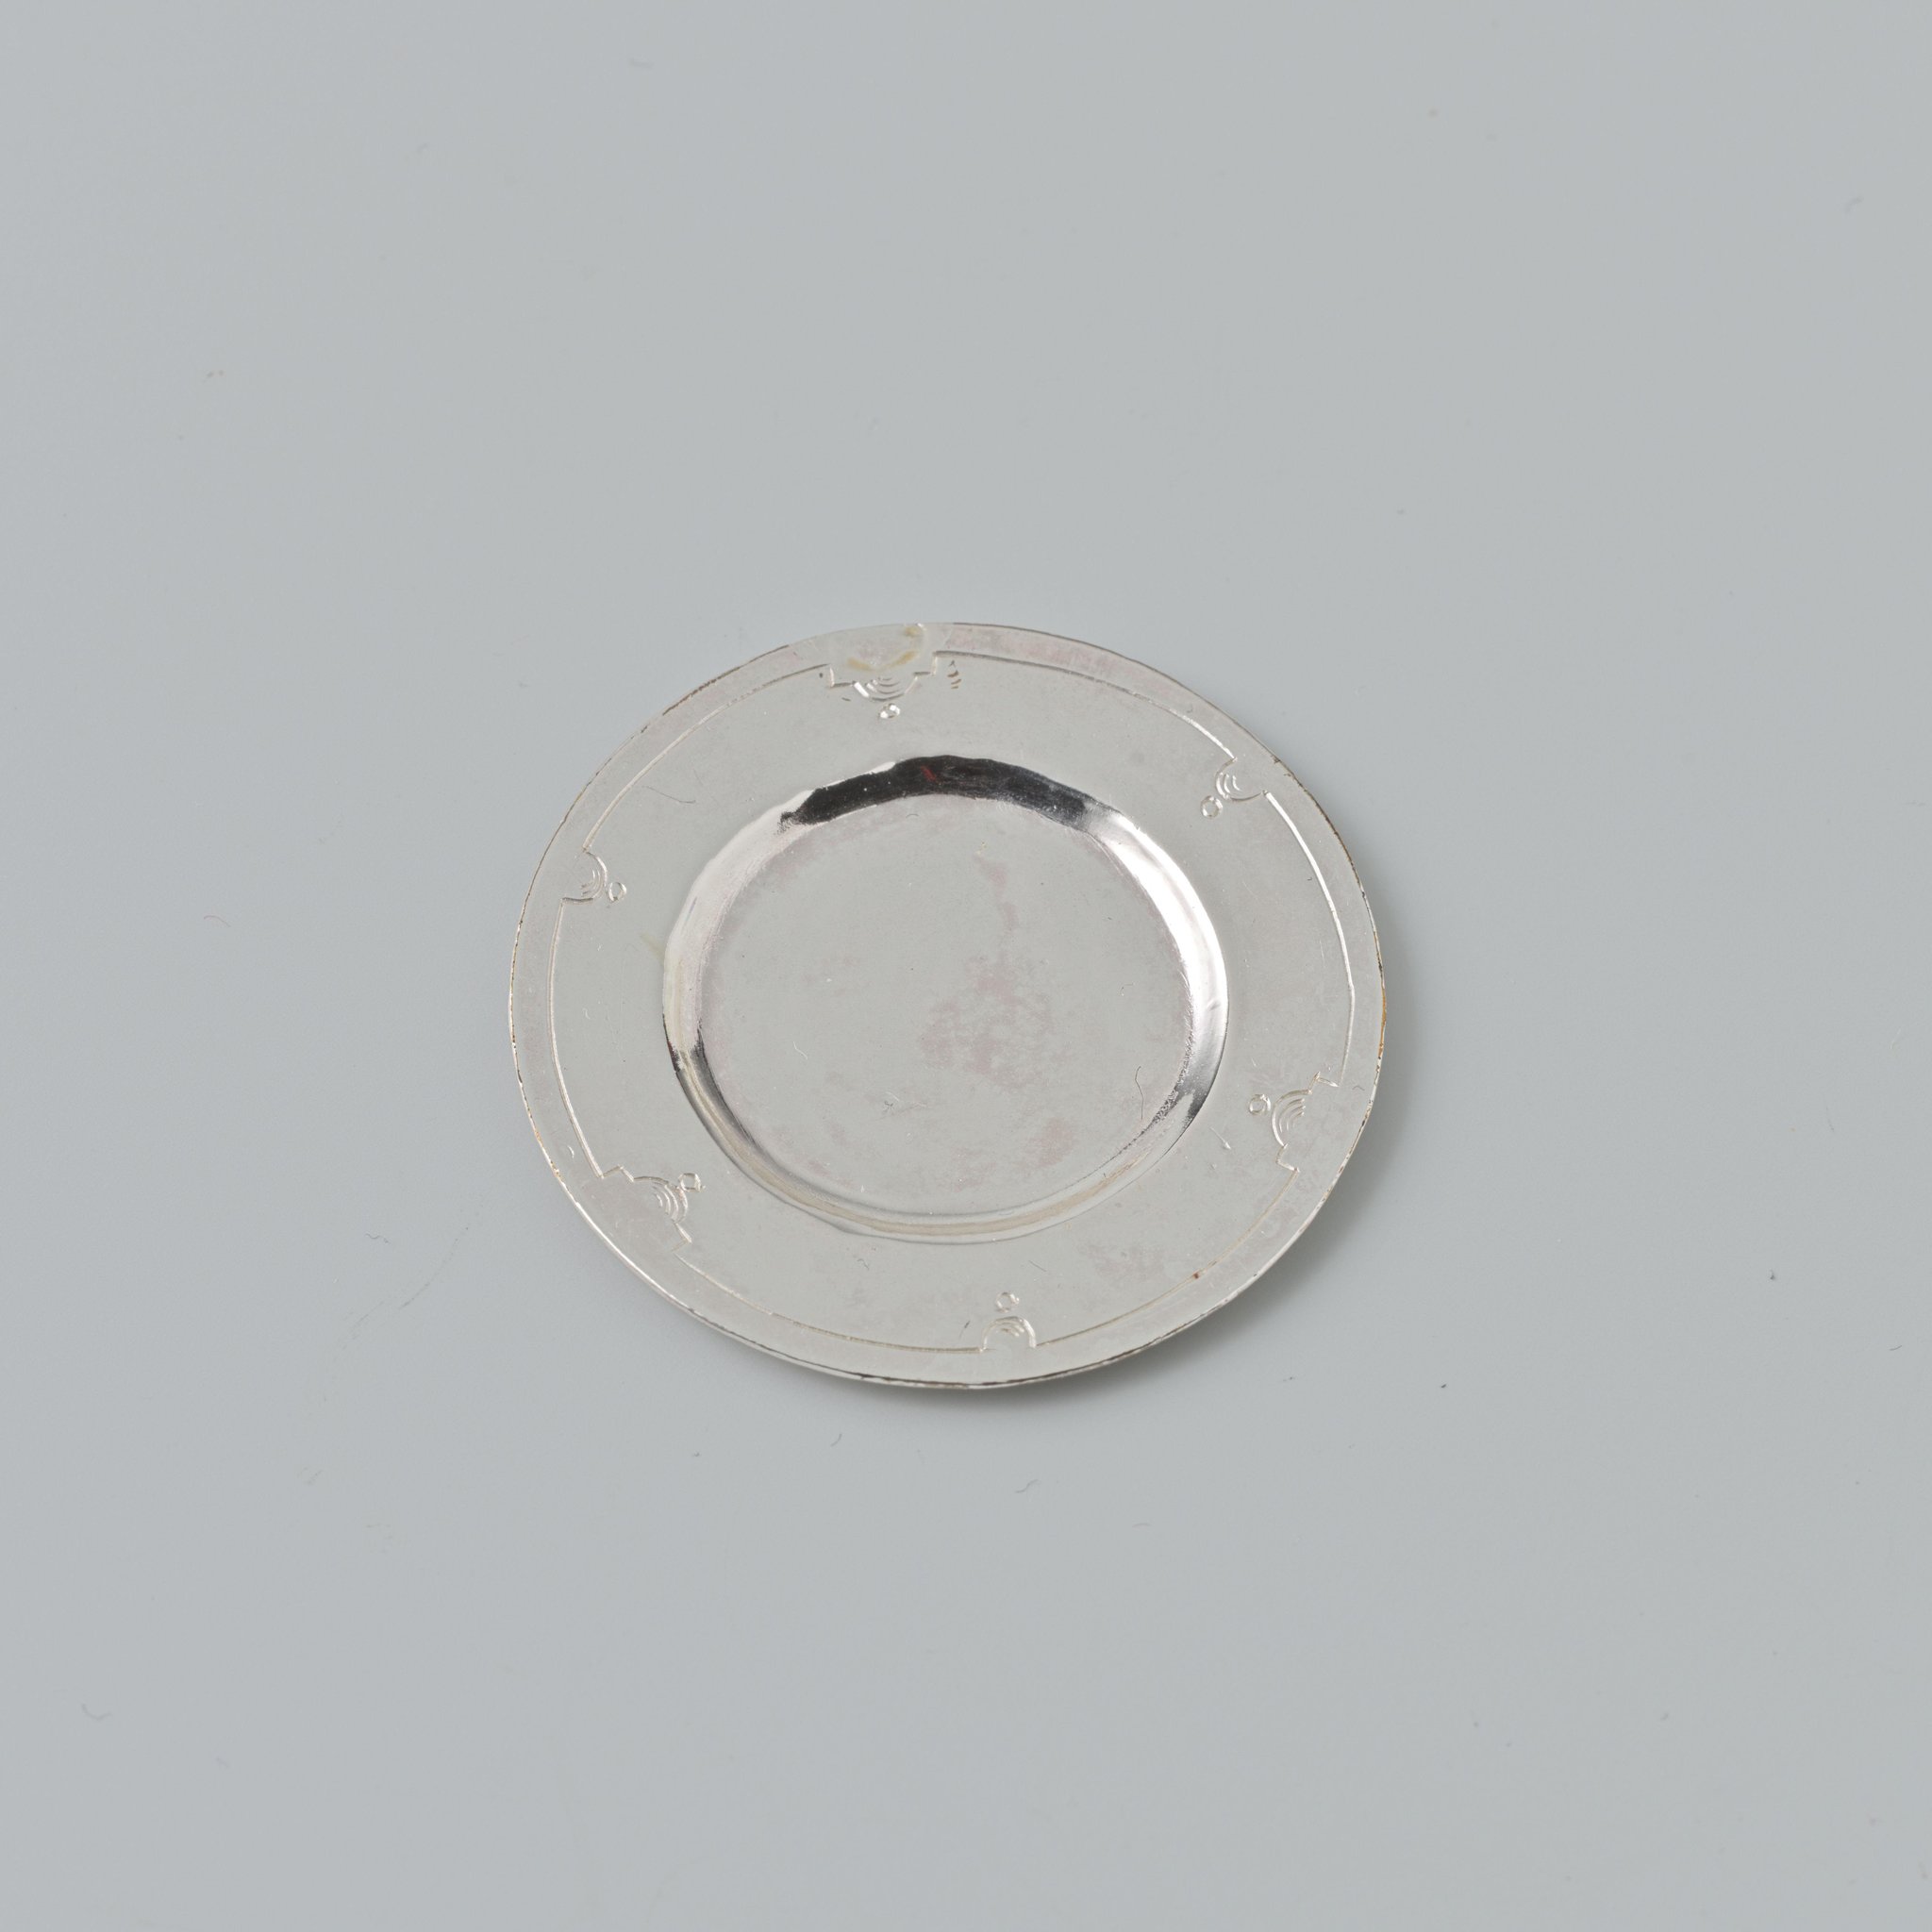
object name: miniature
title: Bord van zilver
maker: Anonymous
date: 1700-1725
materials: silver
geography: amsterdam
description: Bord van zilver met brede rand met groefrand versierd en met lambrequin-achtige motieven.